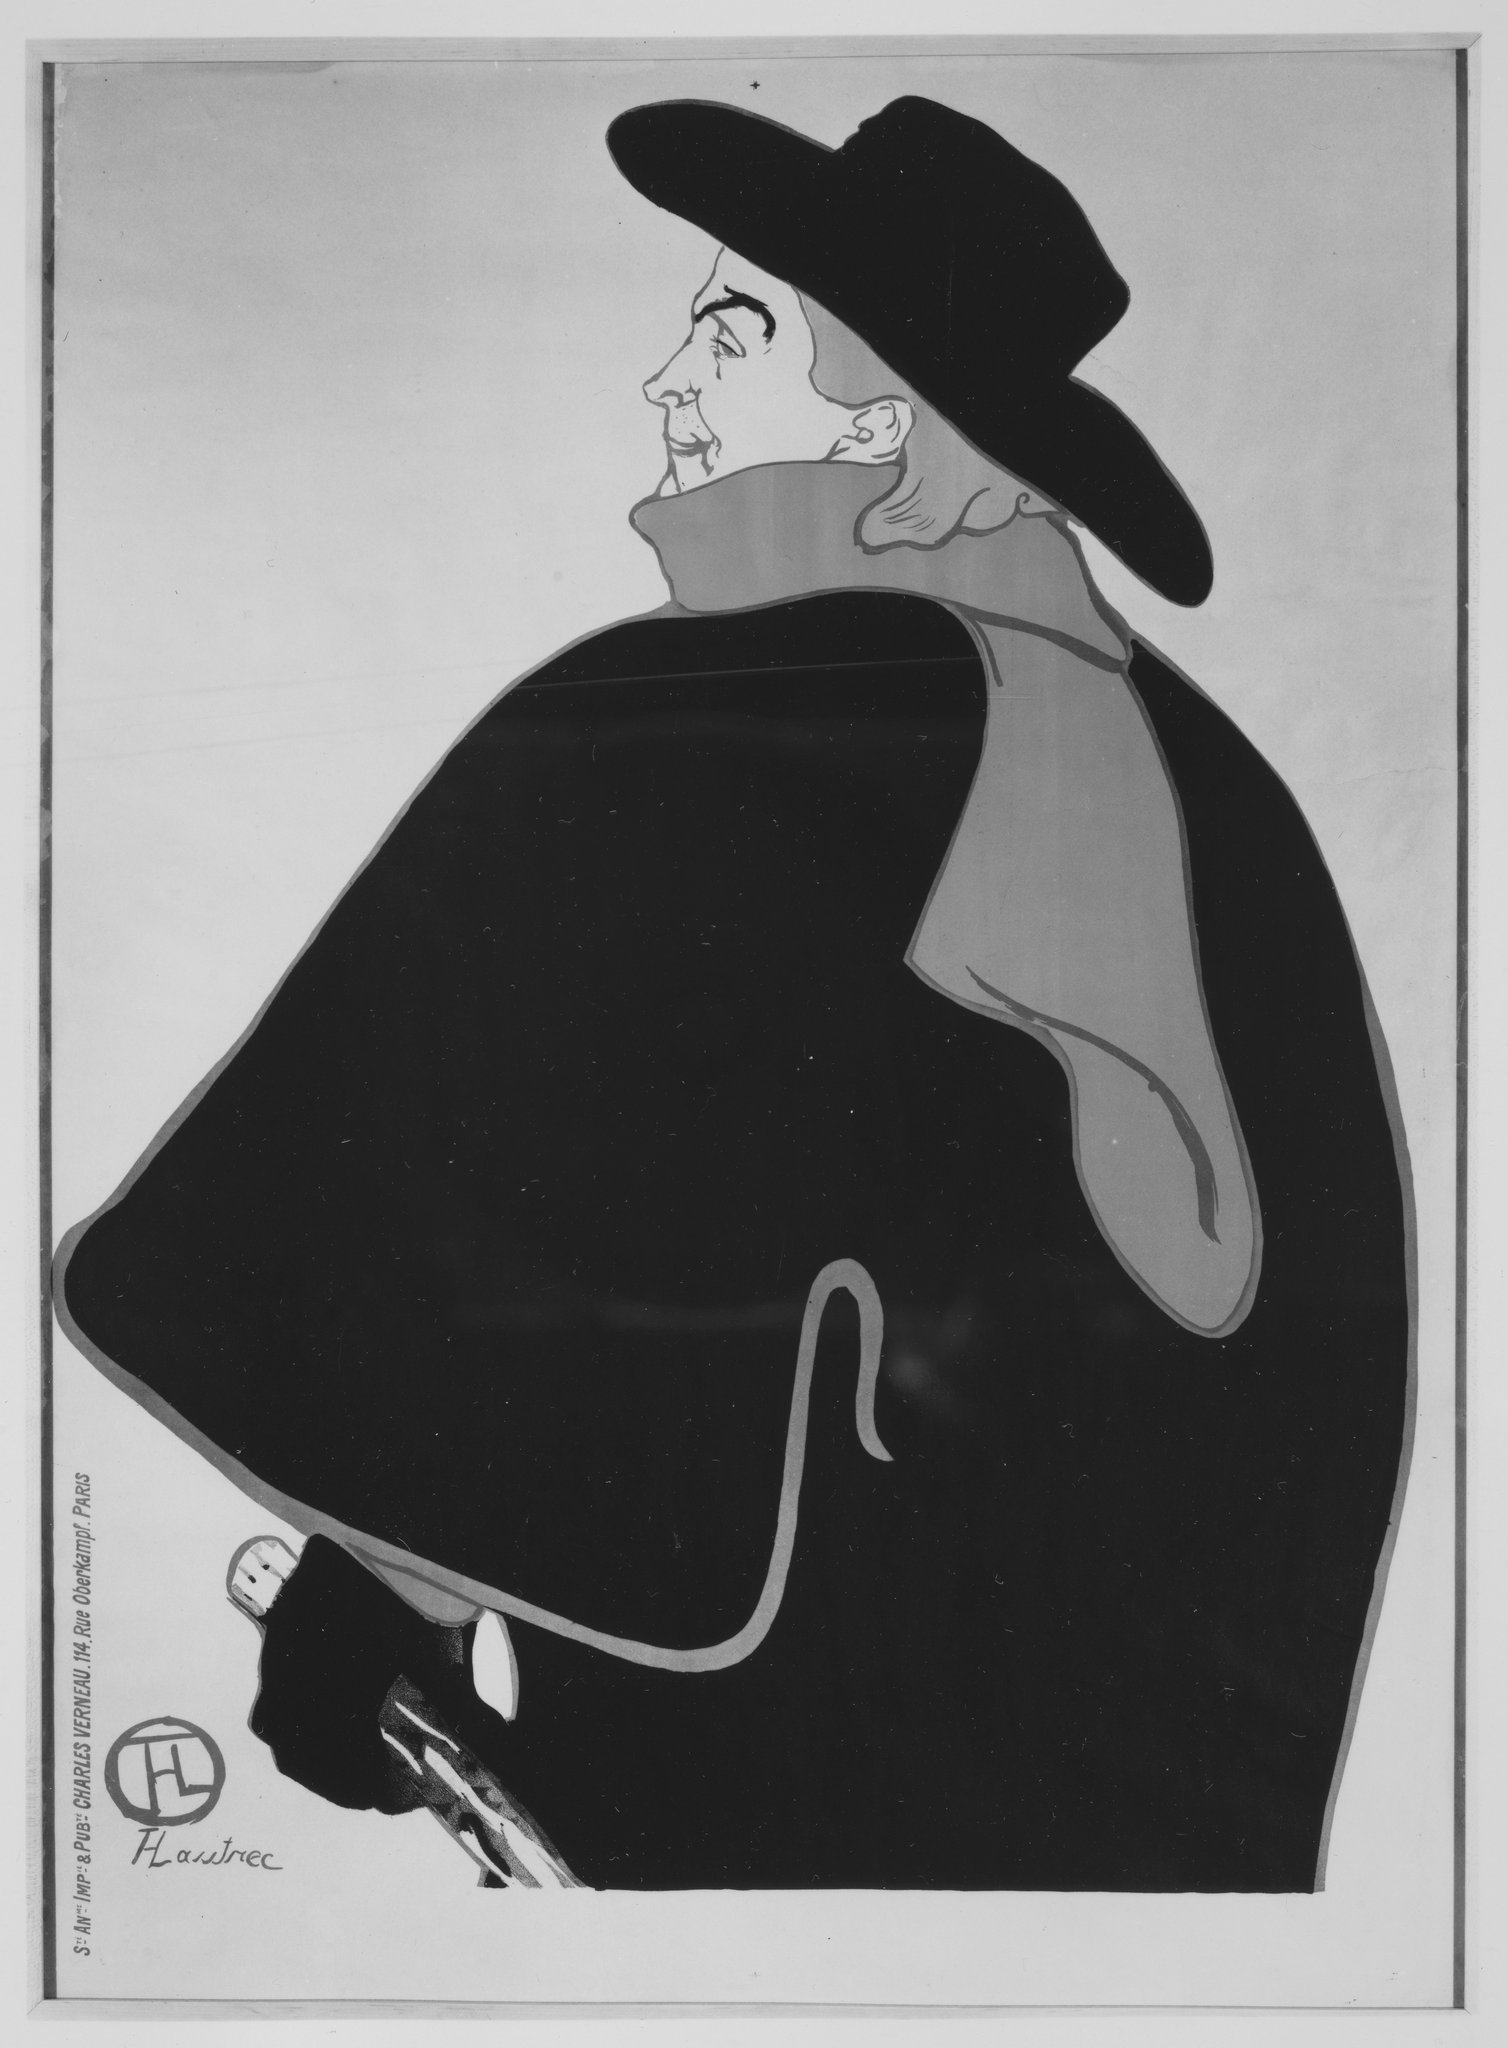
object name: print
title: Aristide Bruant, dans son cabaret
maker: henri de toulouse-lautrec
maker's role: artist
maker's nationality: french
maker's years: 1864-1901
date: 1893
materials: paper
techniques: lithograph, printing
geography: france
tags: men